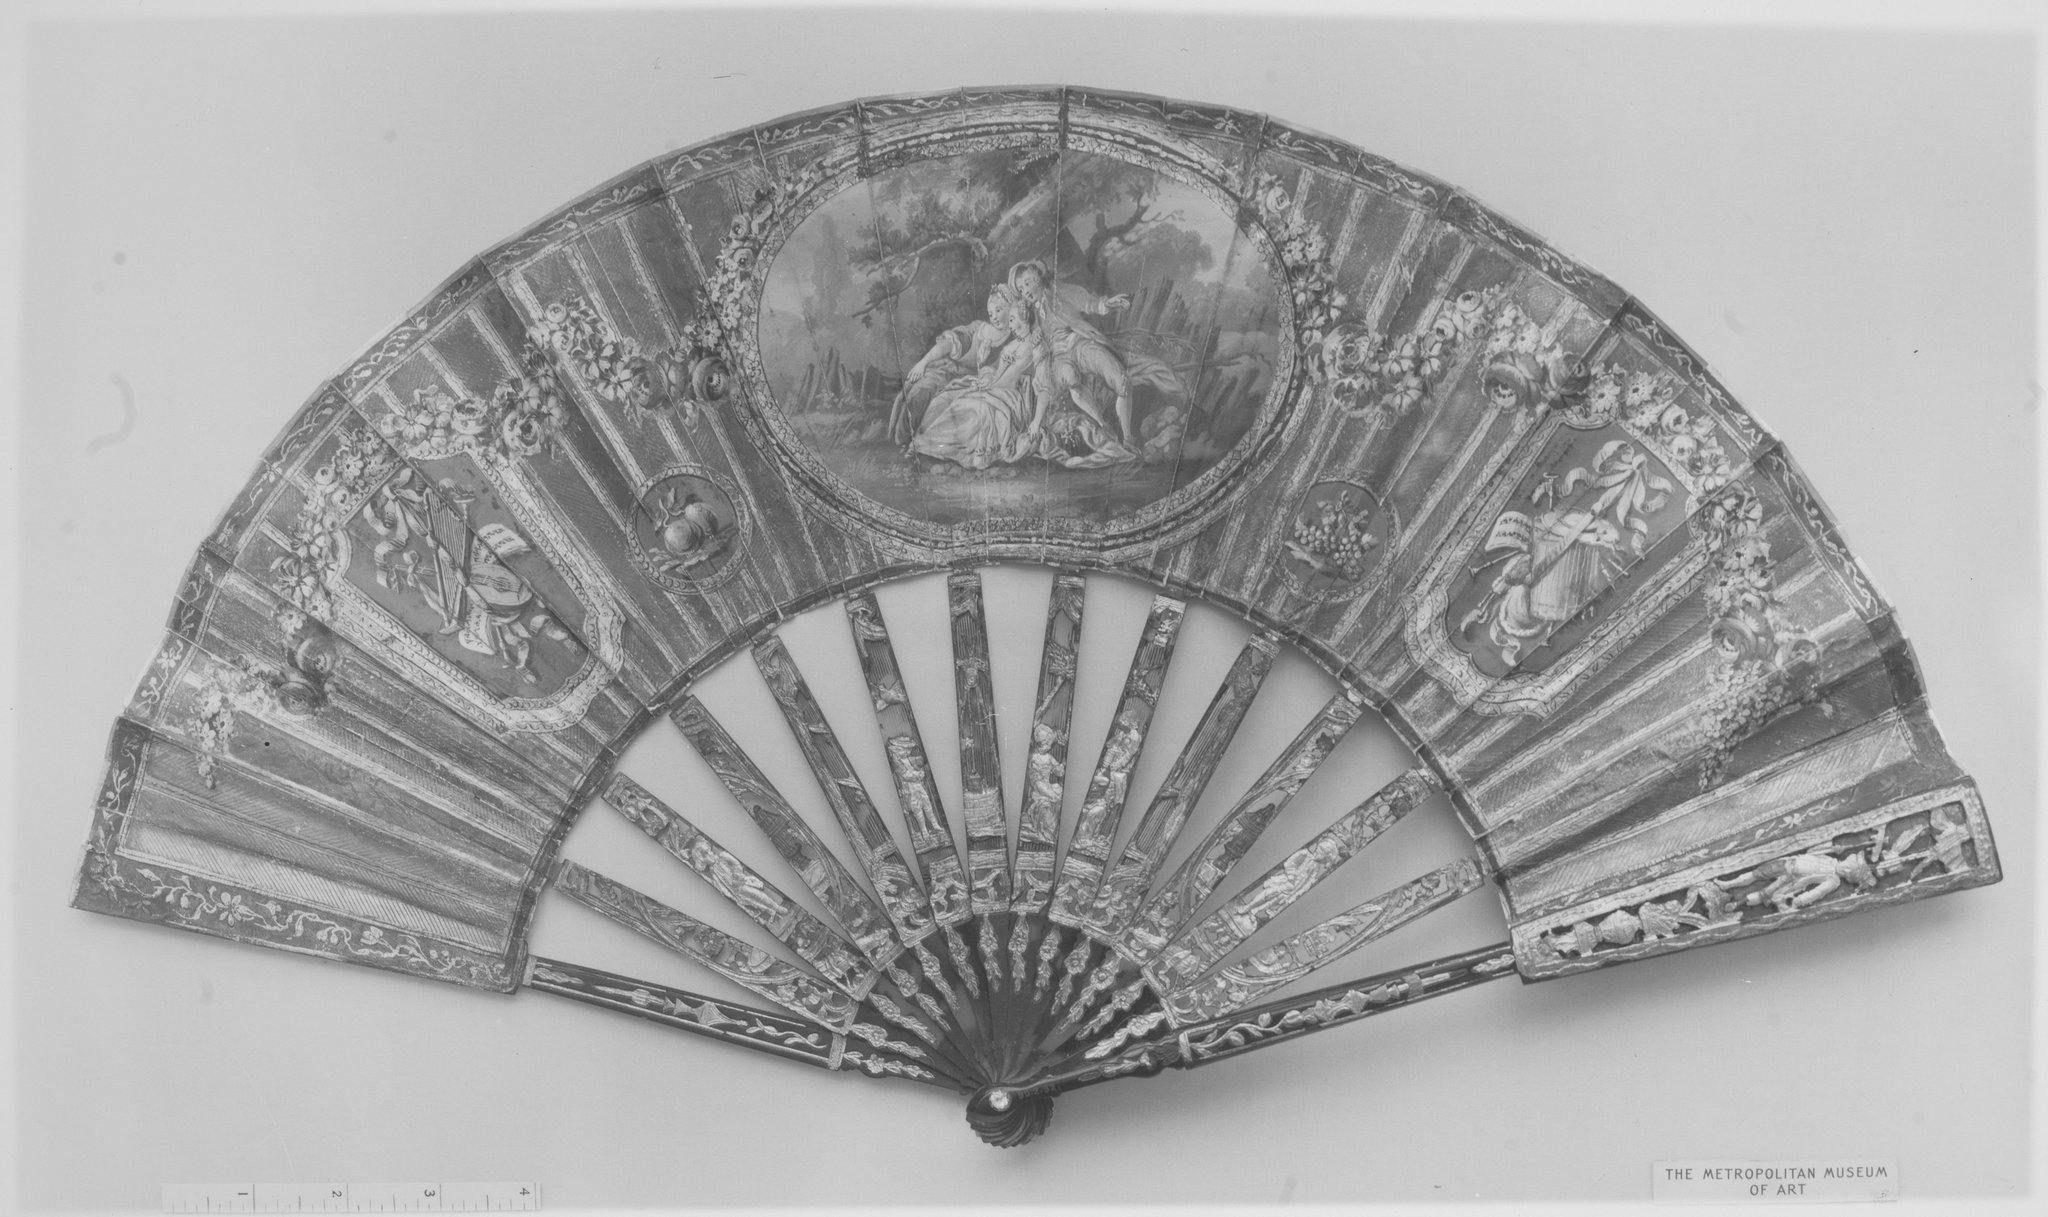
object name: fan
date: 1770-1780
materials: gold, paper, shell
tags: men,women